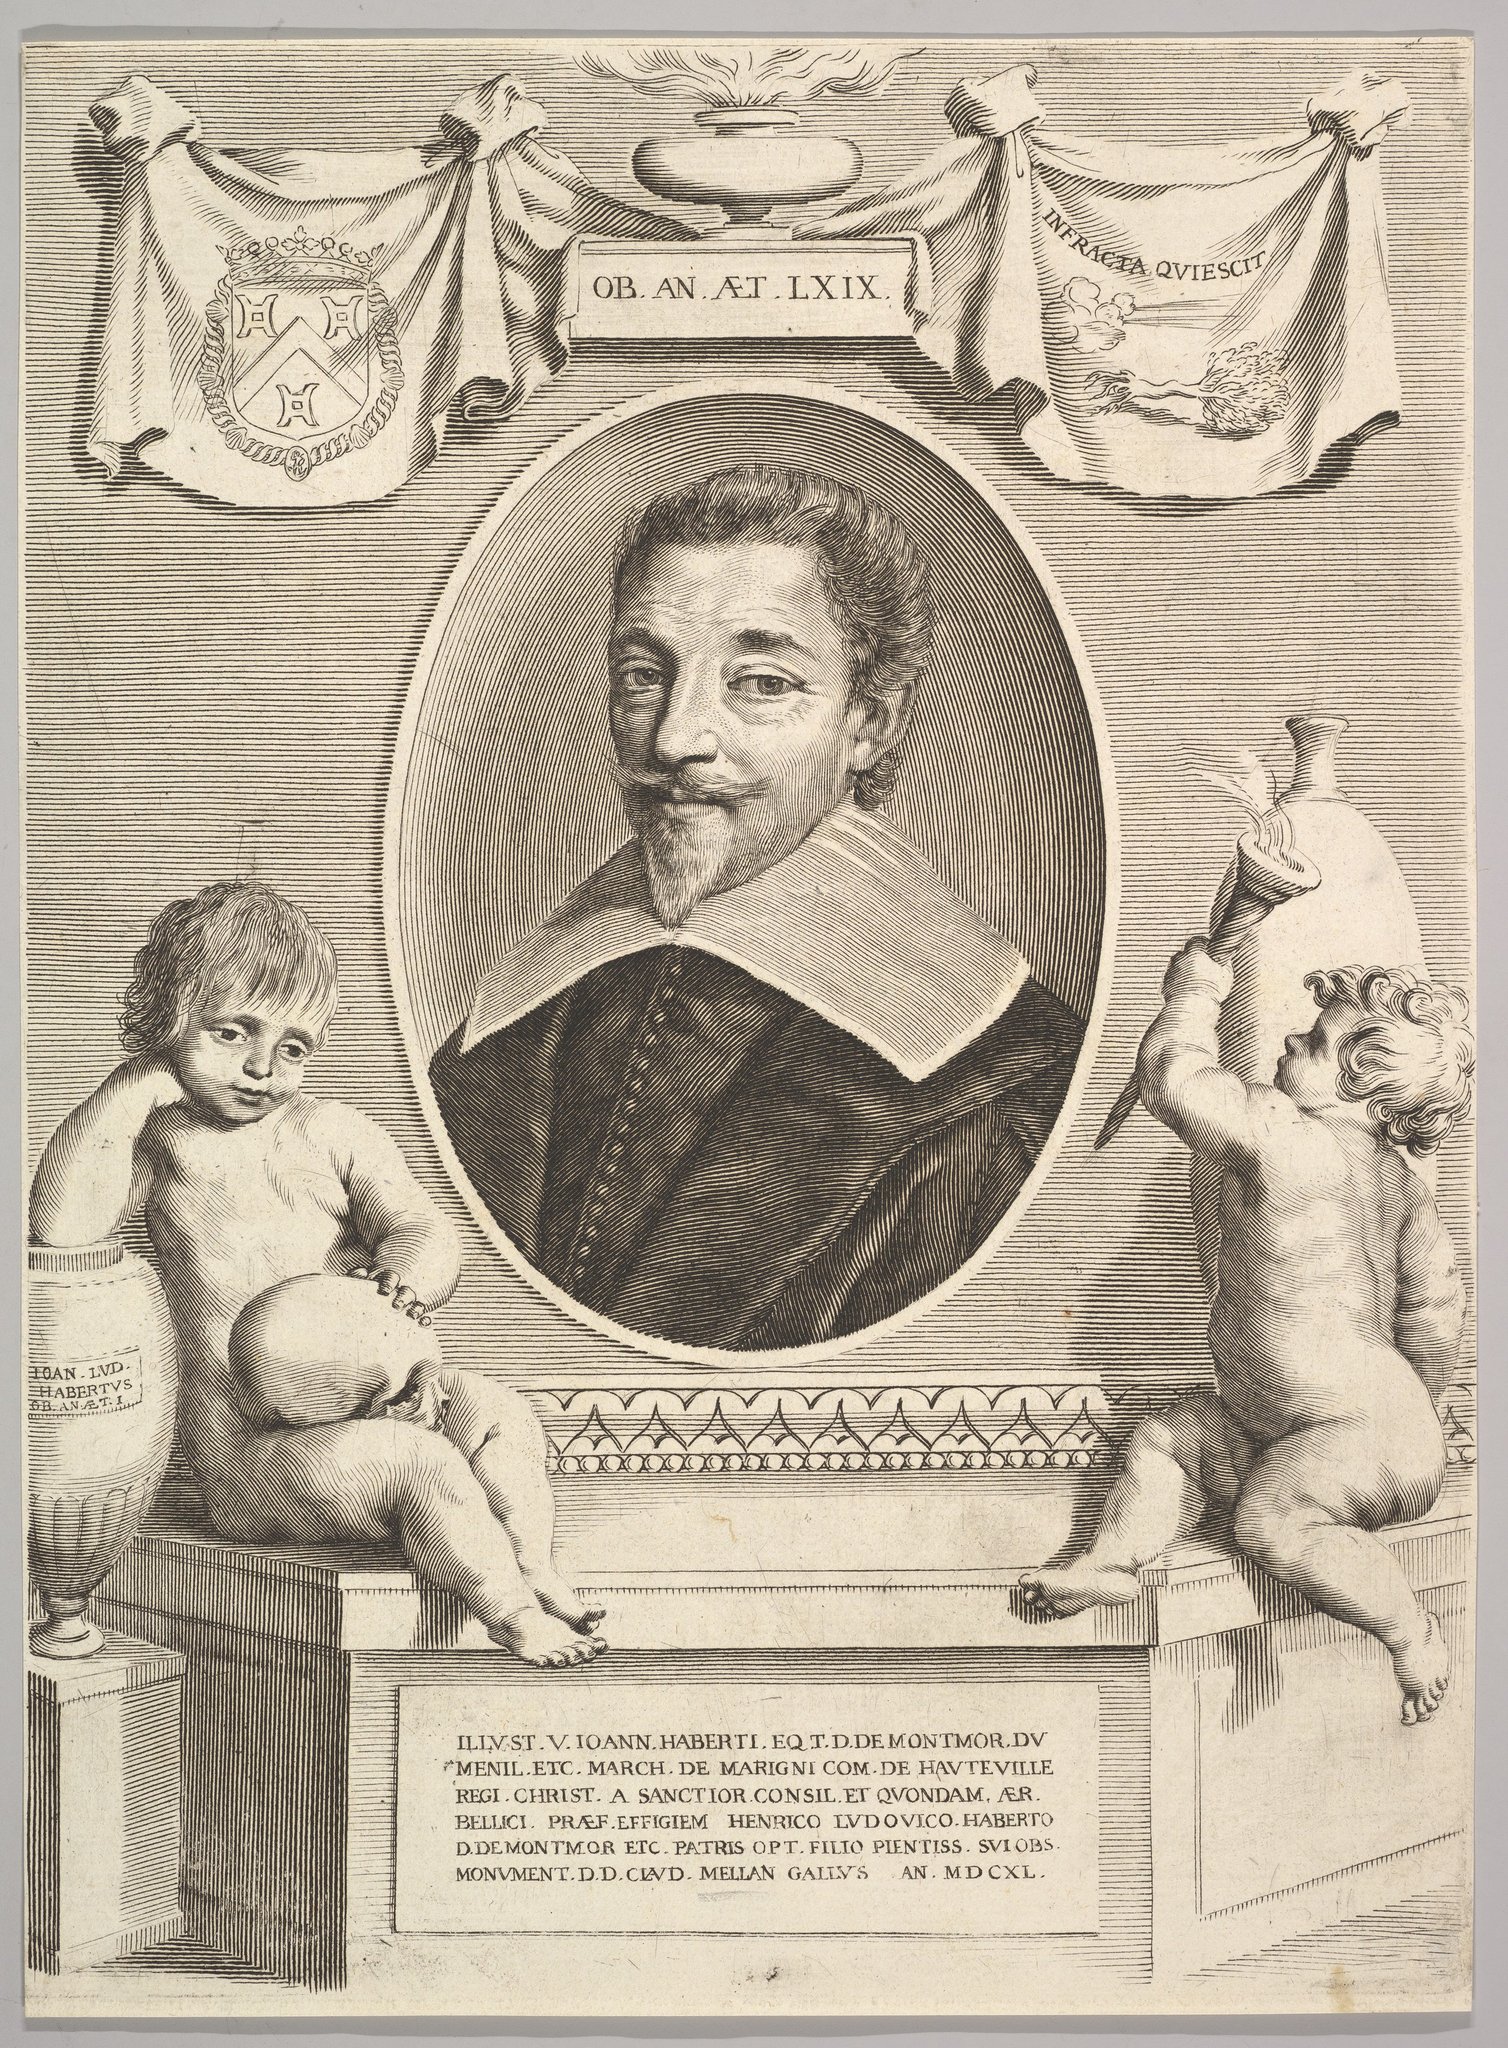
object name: print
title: Jean Habert de Montmor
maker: claude mellan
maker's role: artist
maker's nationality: french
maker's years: 1598-1688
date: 1640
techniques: engraving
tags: children,men,portraits,coat of arms